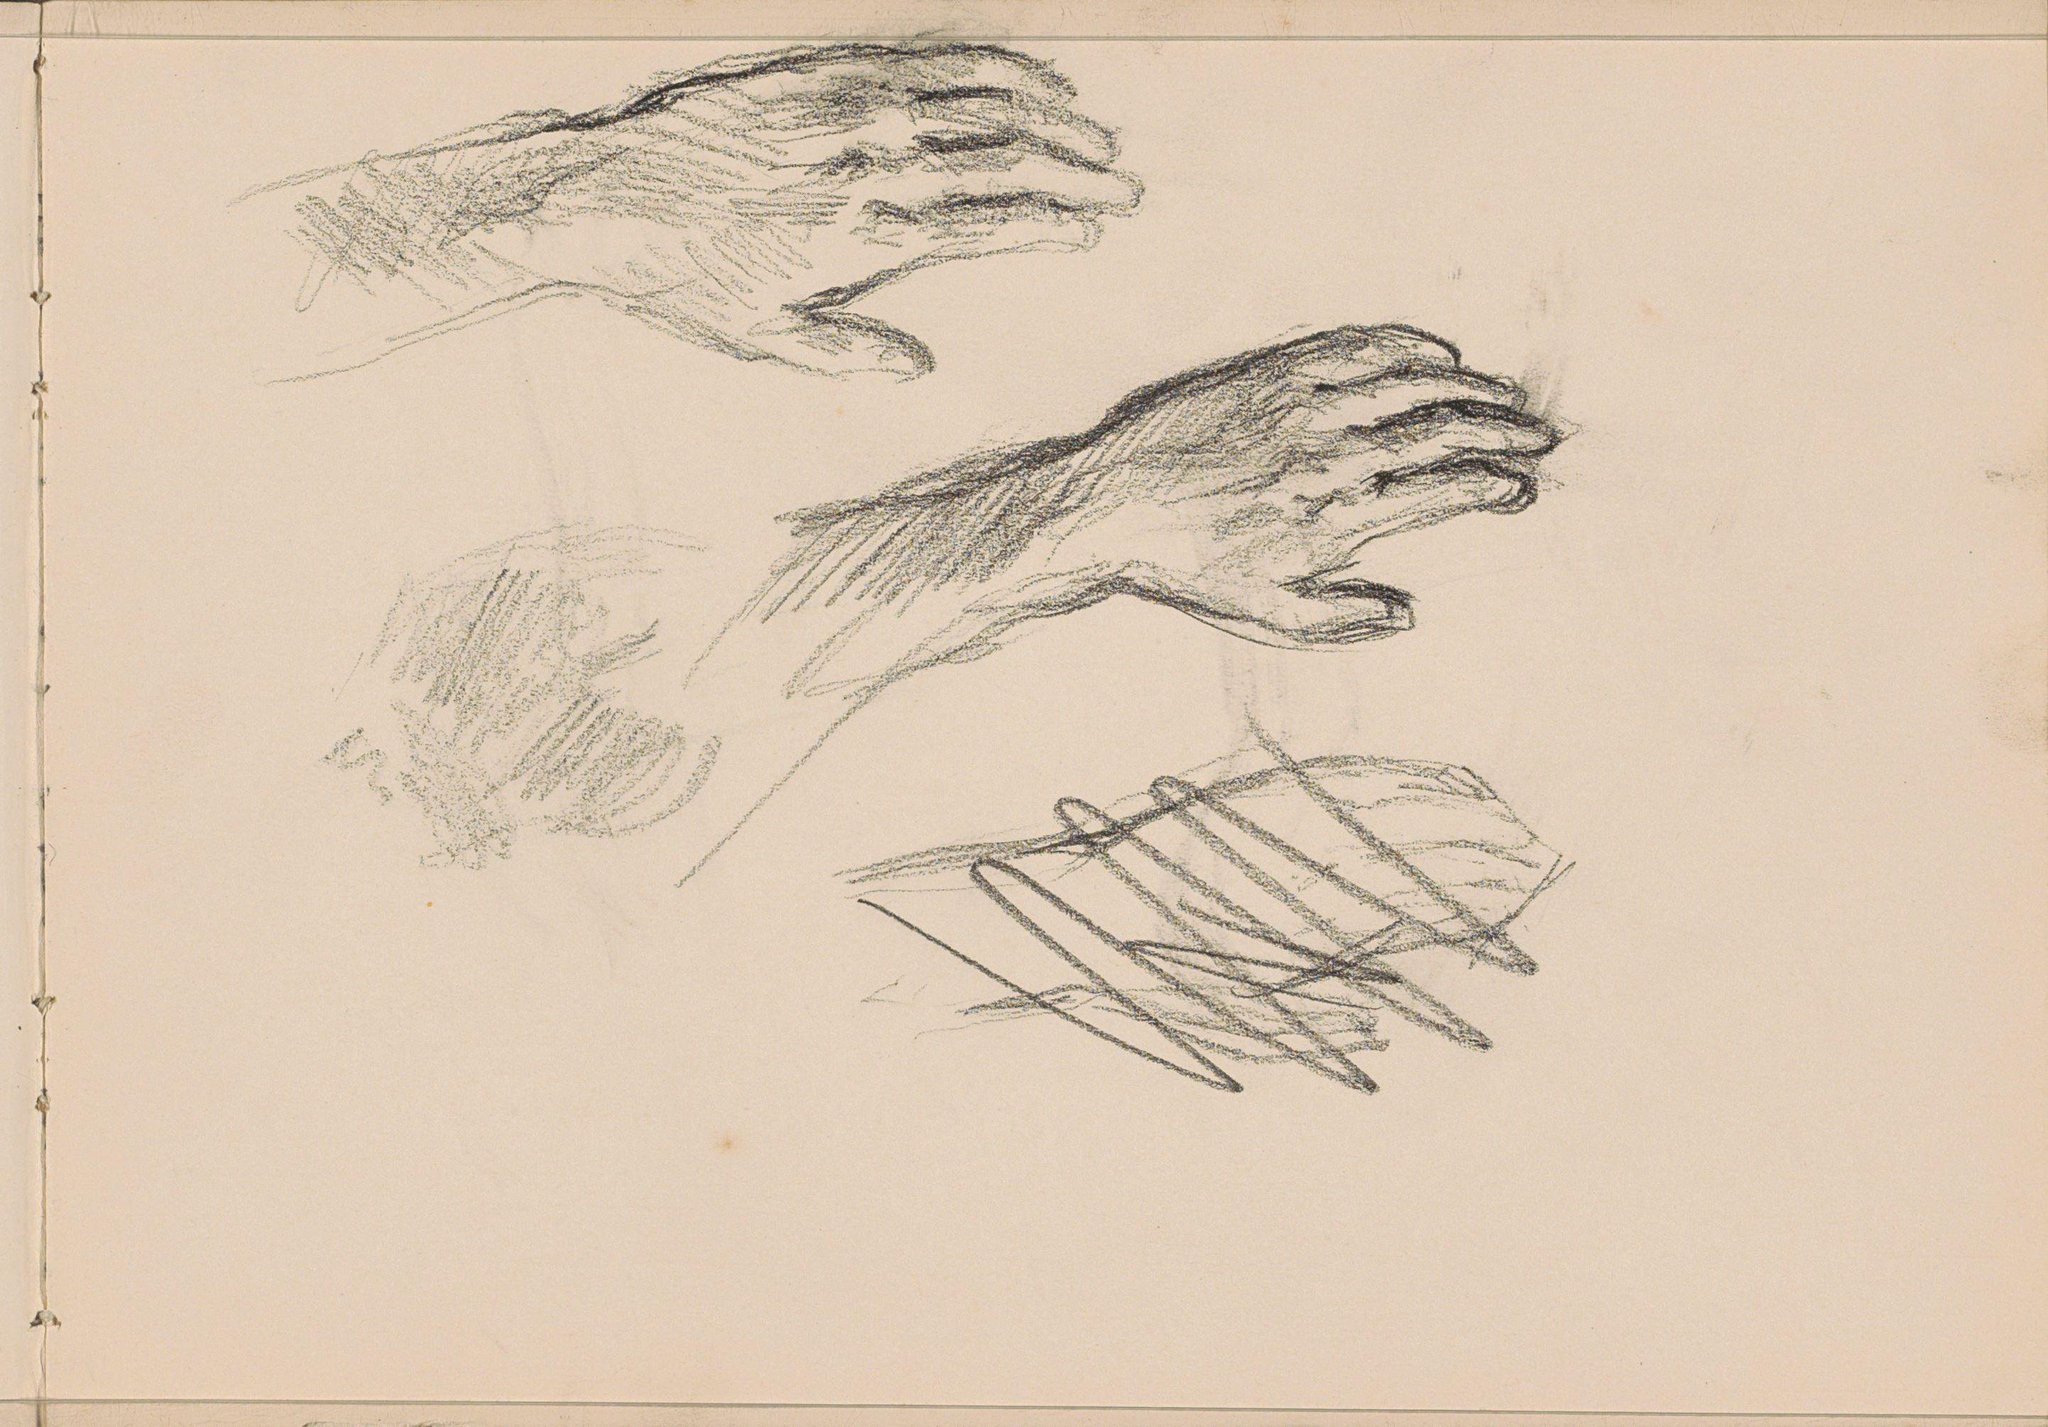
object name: sketchbook leaf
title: Twee handen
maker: a.a.l. de grammont-hubrecht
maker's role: draughtsman, painter, print maker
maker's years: 1855-1913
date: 1865-1913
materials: chalk, paper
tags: hand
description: Blad 15 recto uit een schetsboek met 68 bladen.